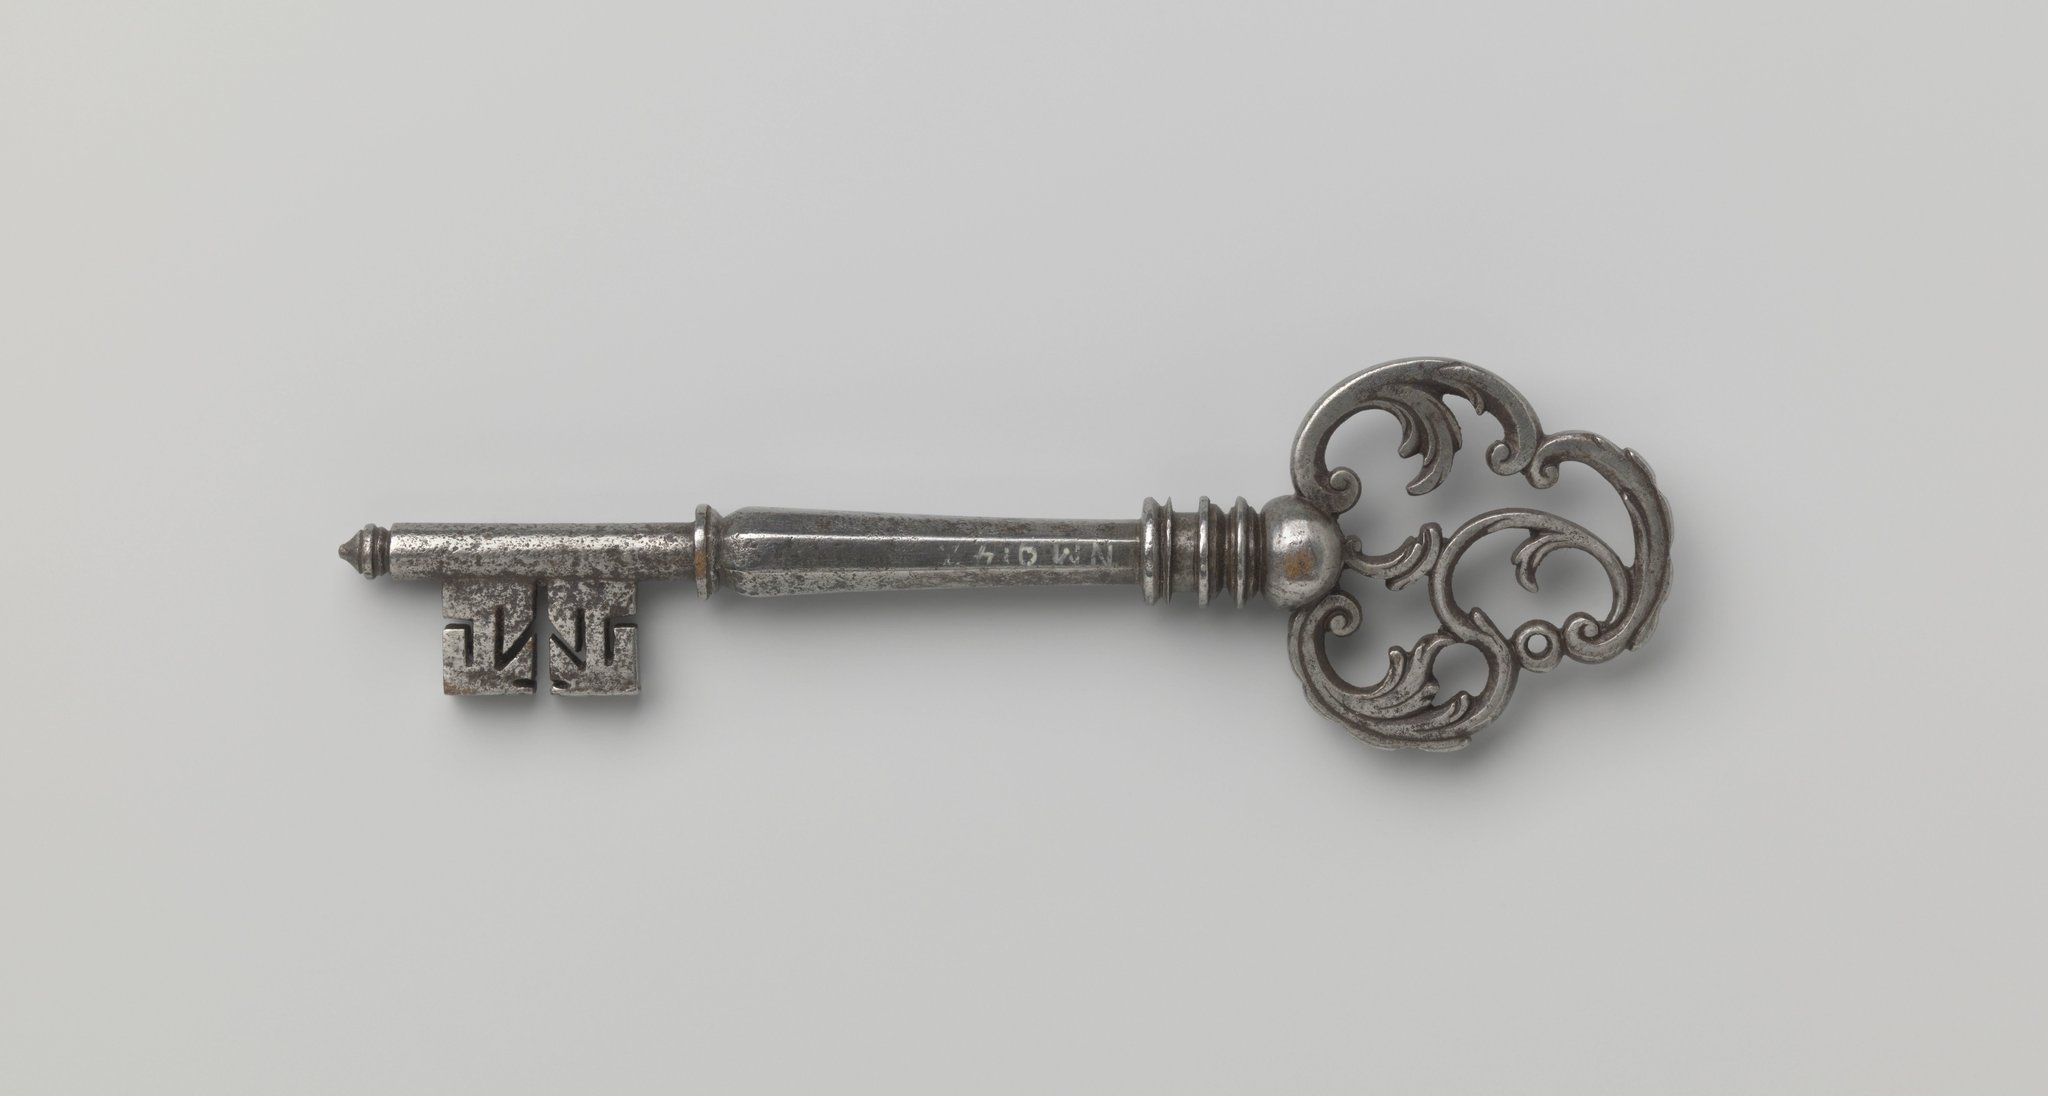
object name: key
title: Sleutel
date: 1725-1775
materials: iron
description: Sleutel. Steel: achtkantig, naar de ring toe smaller toelopend. Ring: asymmetrische blad-ranken. Baard: in twee helften verdeeld, met rechte voorkanten, in beide helften symetrische inkepingen